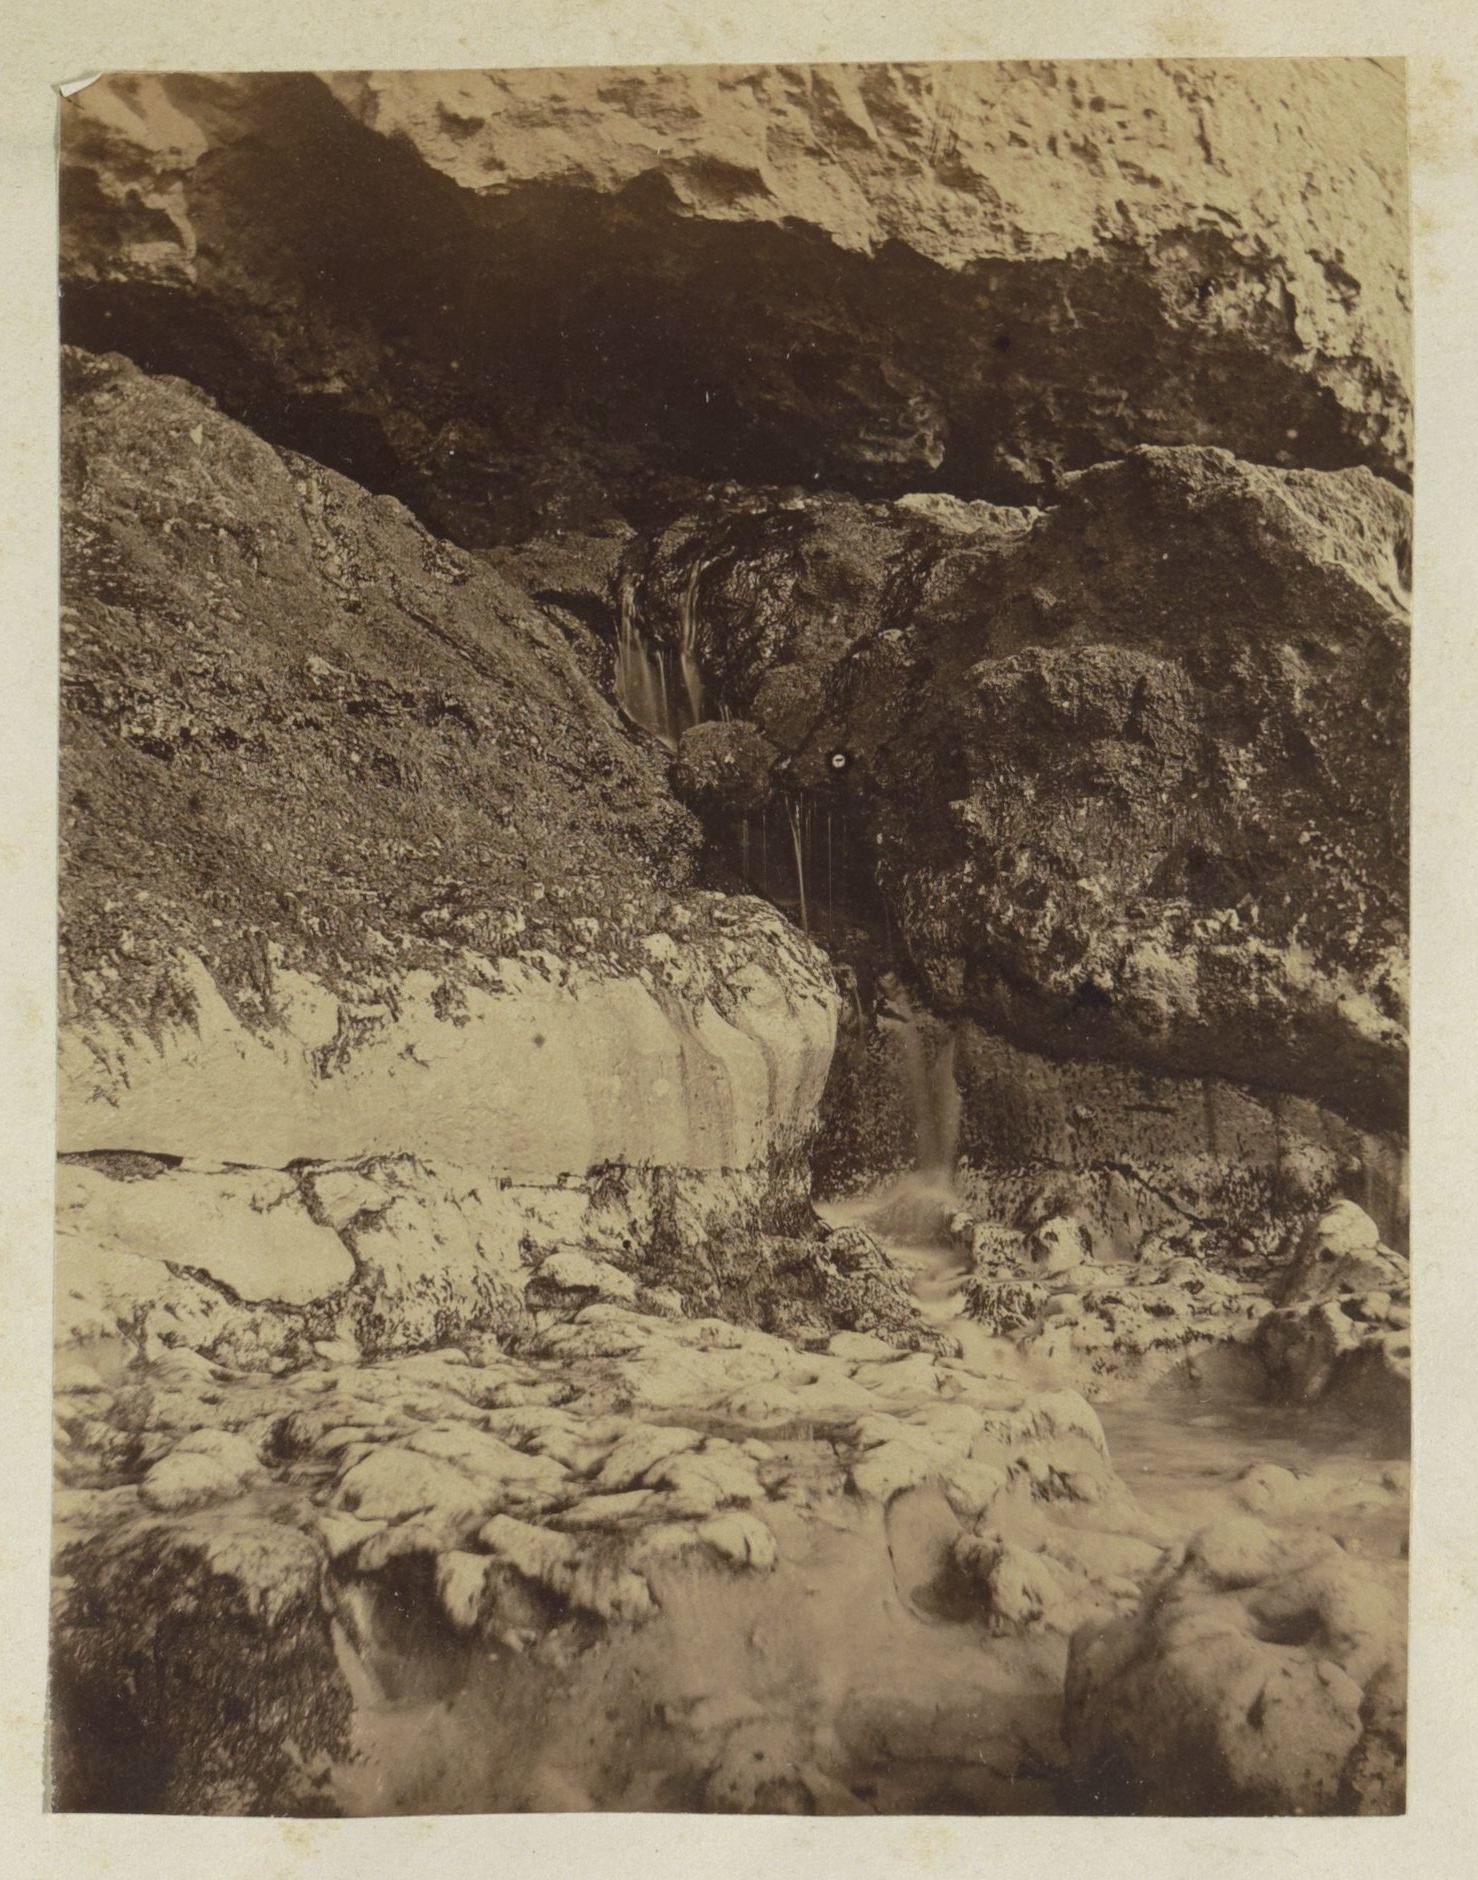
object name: photograph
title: Rotsformatie met beek in Frankrijk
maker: Anonymous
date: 1809-1883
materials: photographic support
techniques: albumen print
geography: france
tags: rock-formations, france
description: Onderdeel van Album van een Franse amateurfotograaf met opnames van familie, militairen, industrie, landschappen en bezienswaardigheden in Frankrijk.